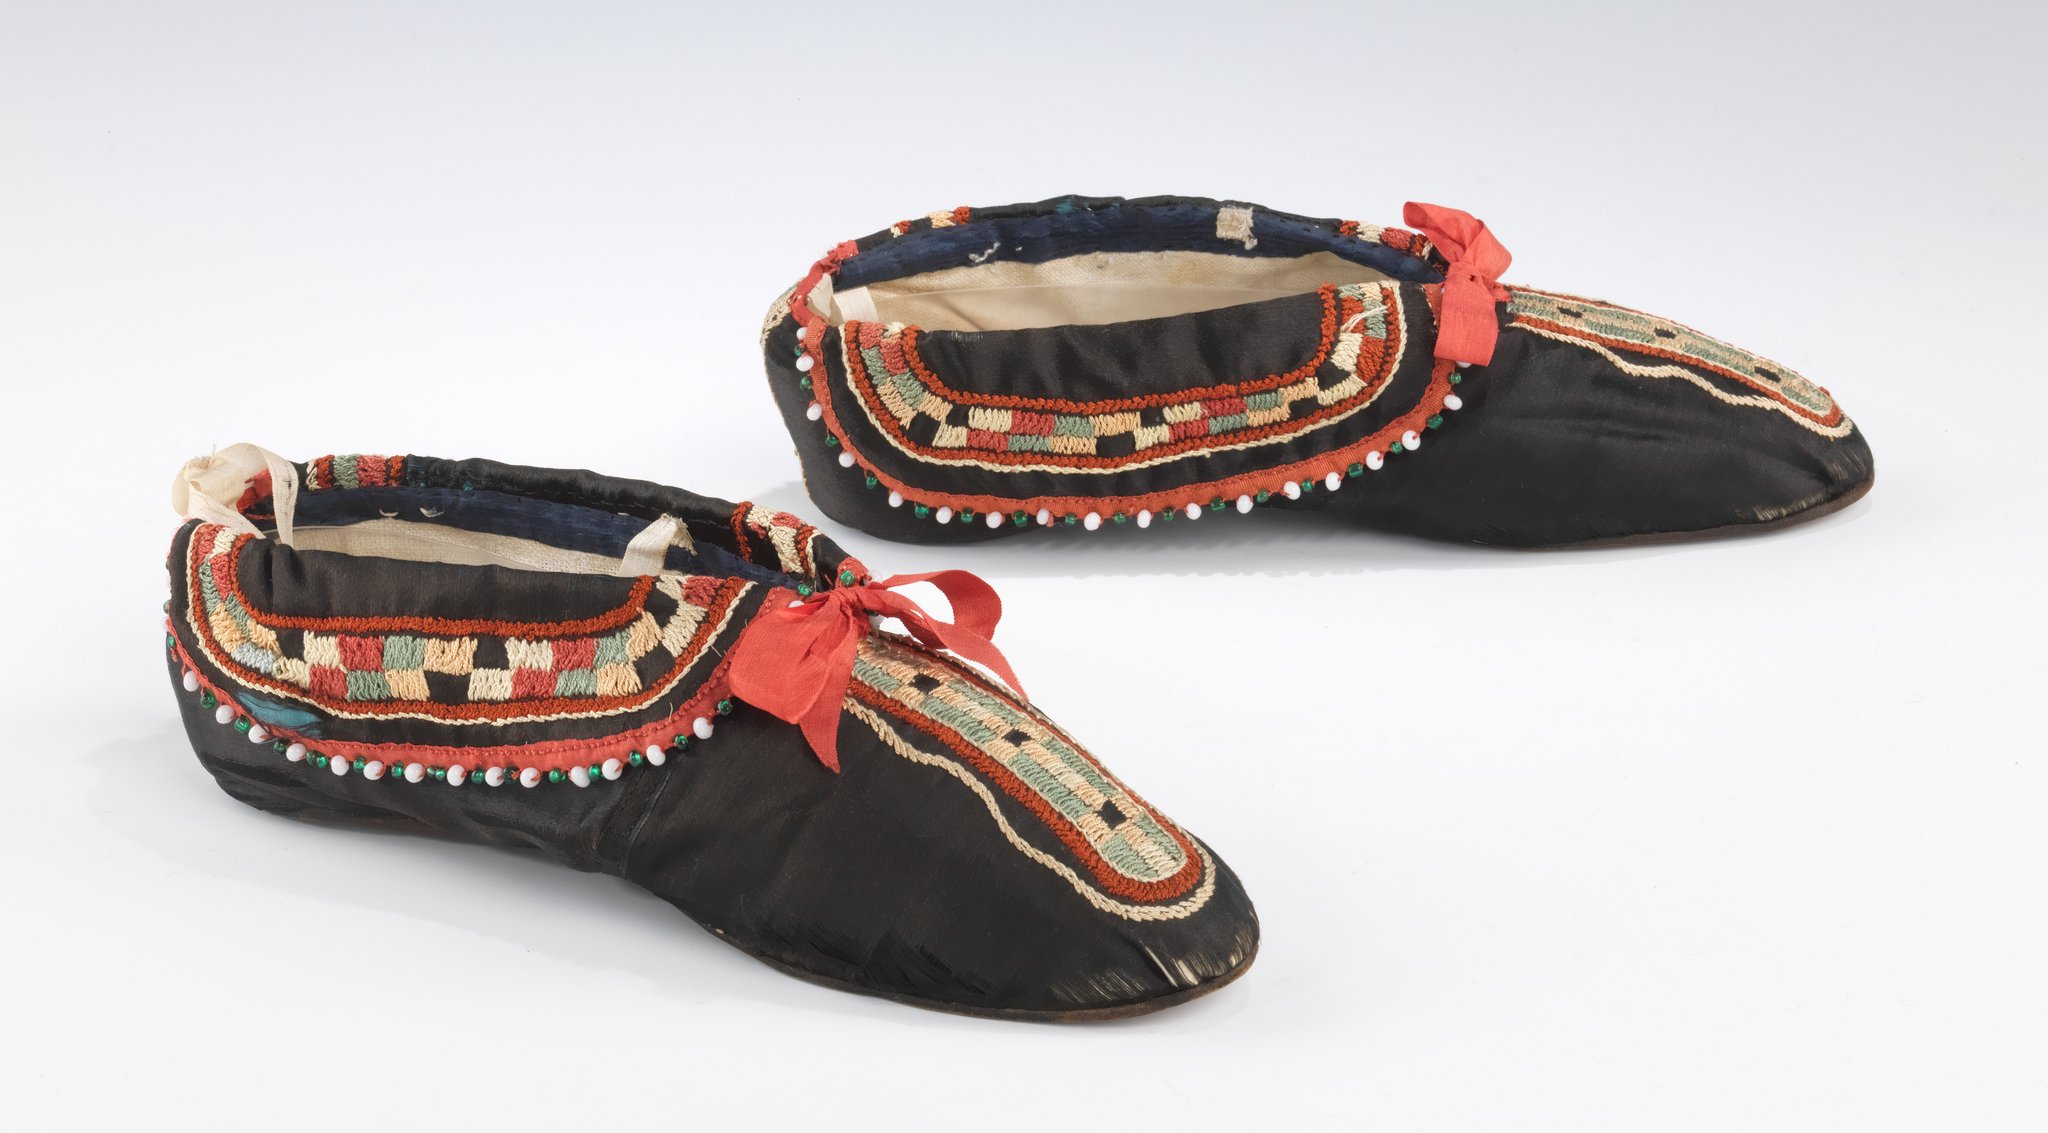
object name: slipper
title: Slippers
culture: british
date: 1825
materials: silk